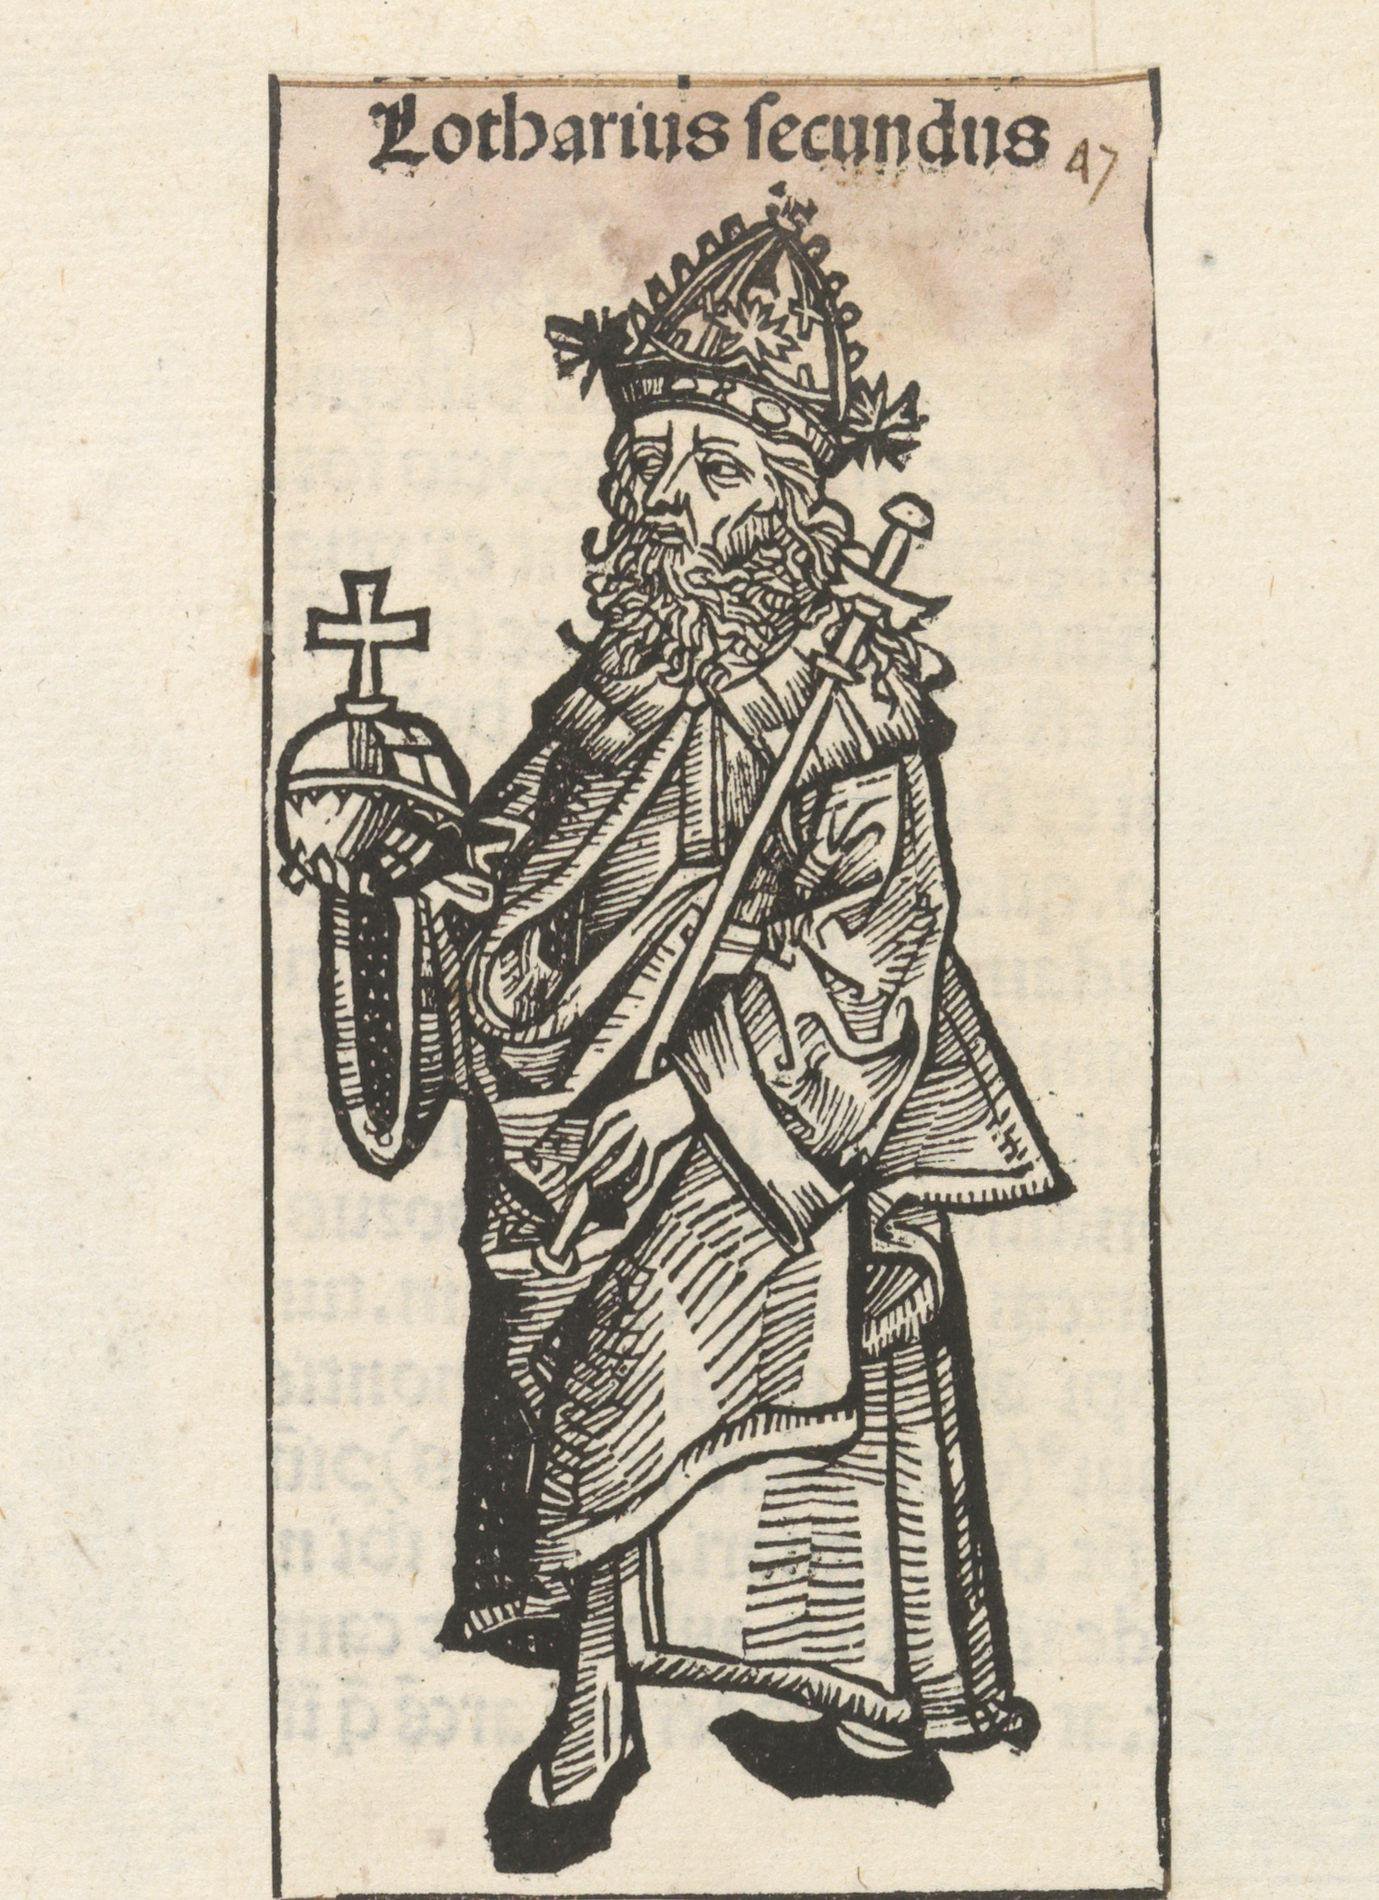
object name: album leaf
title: Keizer Lotharius III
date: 1493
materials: paper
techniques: letterpress printing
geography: nuremberg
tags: emperor, king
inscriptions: inscription: ‘47’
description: Een koning met rijksappel en scepter, ten voeten uit. De voorstelling is onderdeel van de opeenvolging keizers in de Liber Chronicarum. De tekst identificeert de man als keizer Lotharius III. De prent maakt deel uit van een album.